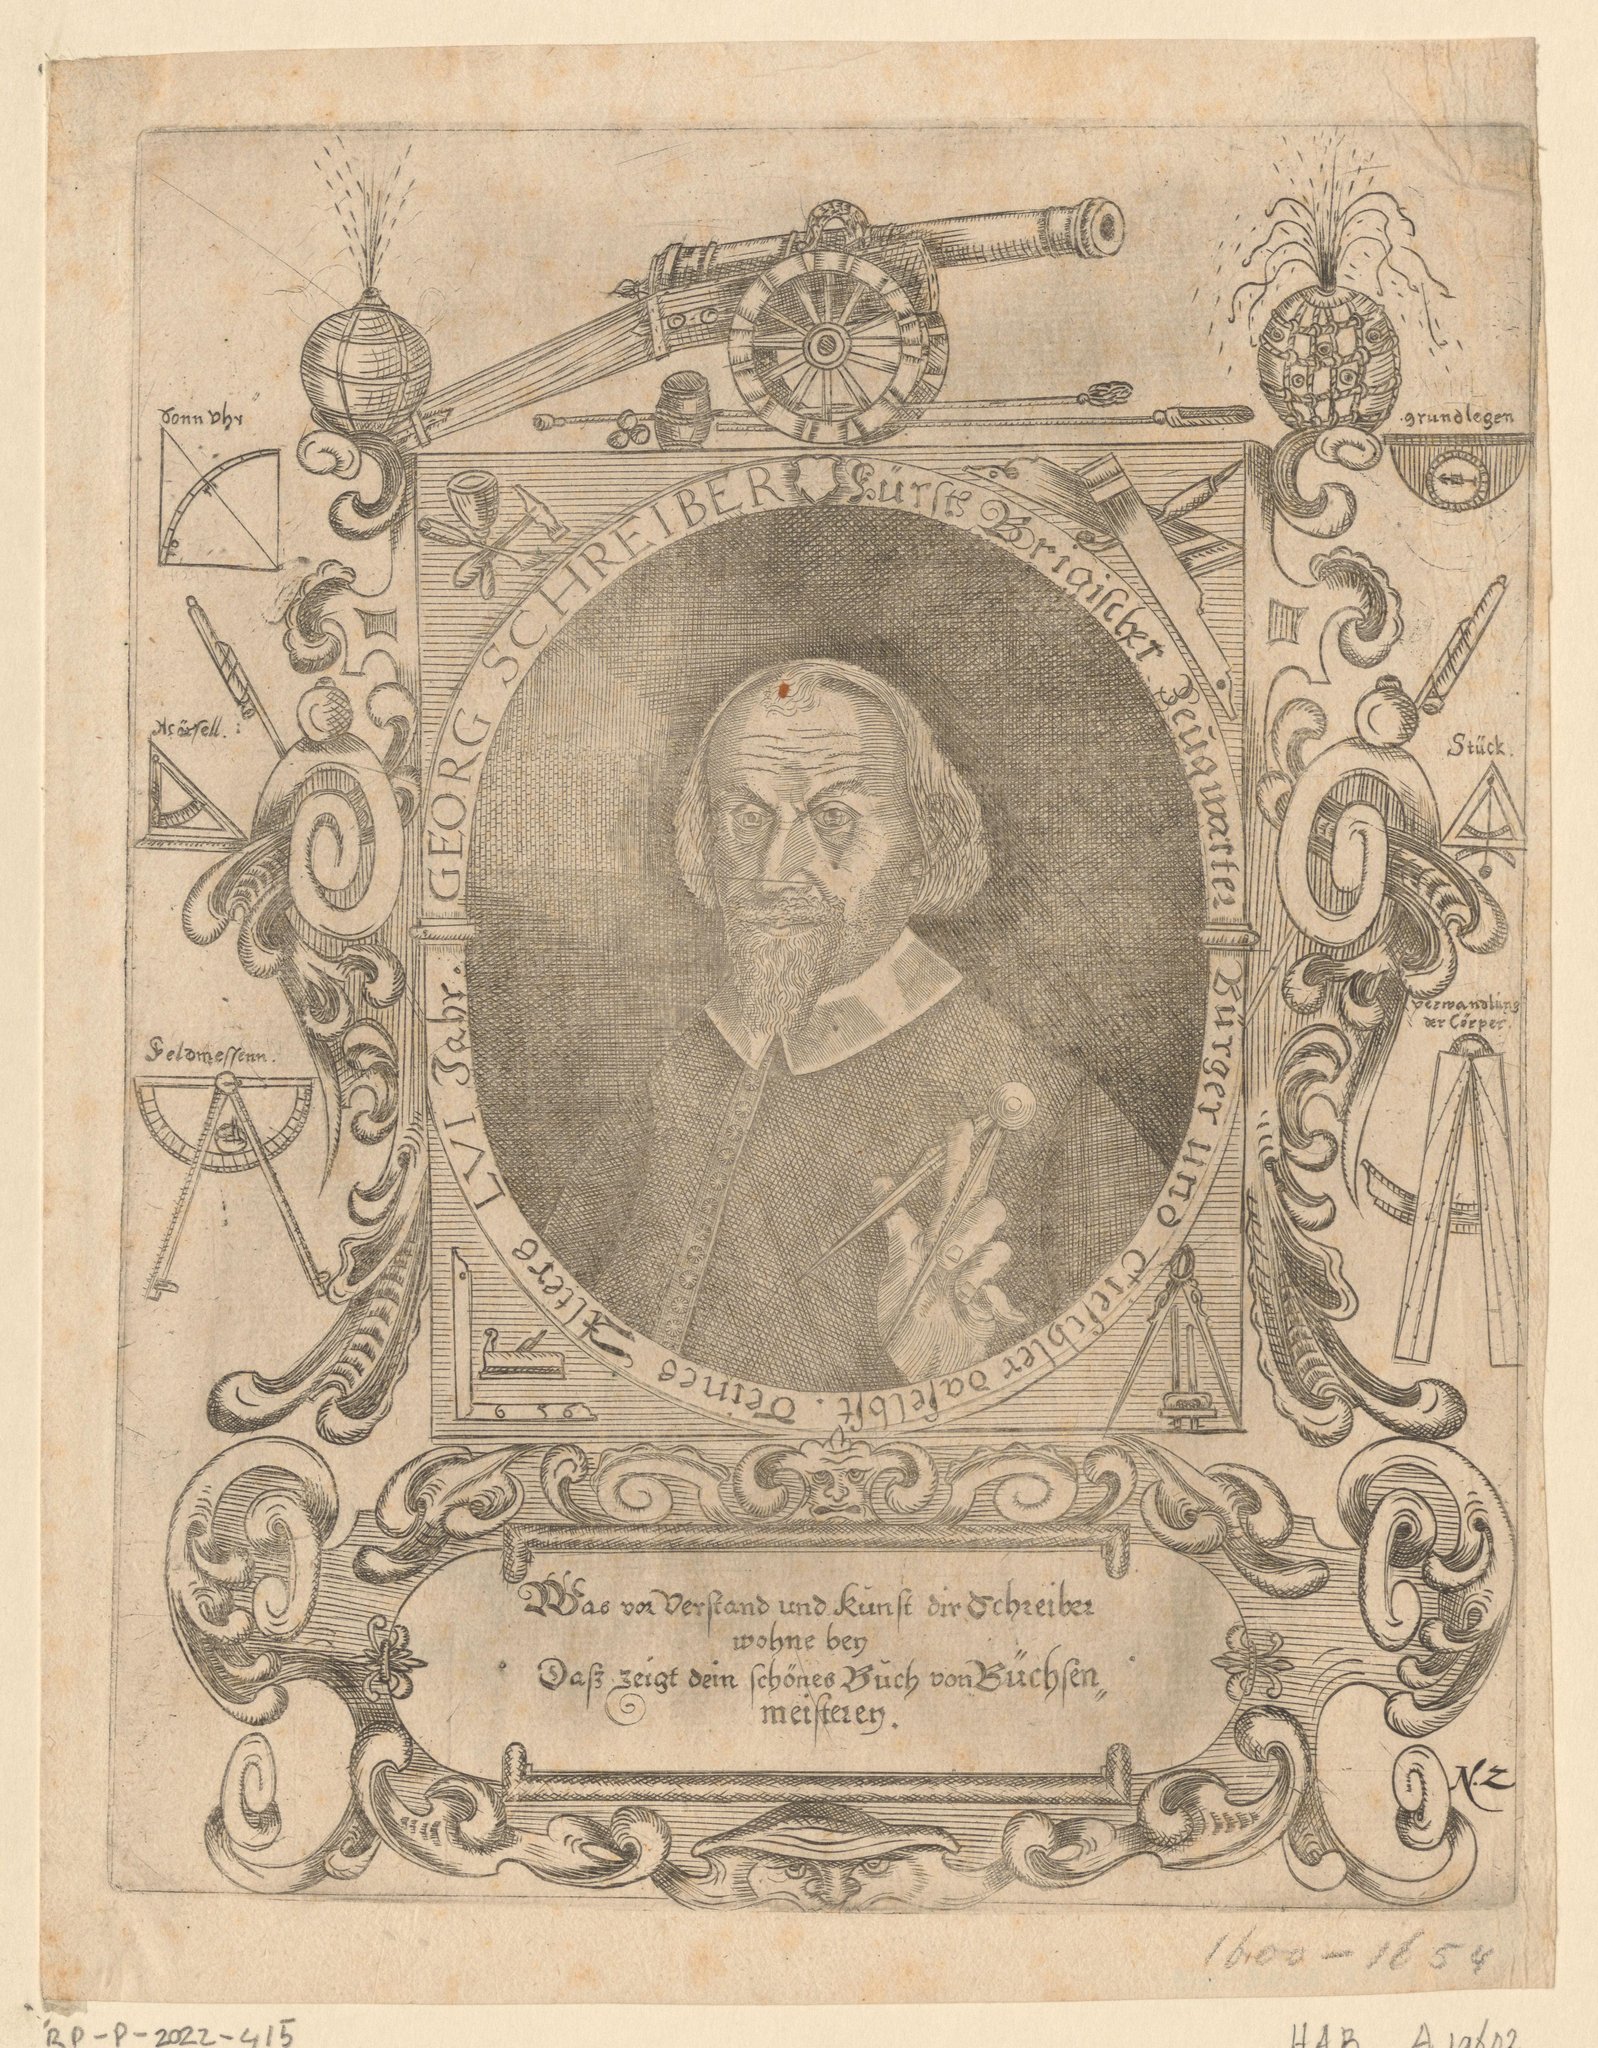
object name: print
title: Portret van Georg Schreiber op 56-jarige leeftijd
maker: Anonymous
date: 1656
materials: paper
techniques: engraving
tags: carpenter, historical persons, measuring-instruments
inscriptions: monogram: ‘N.Z.’